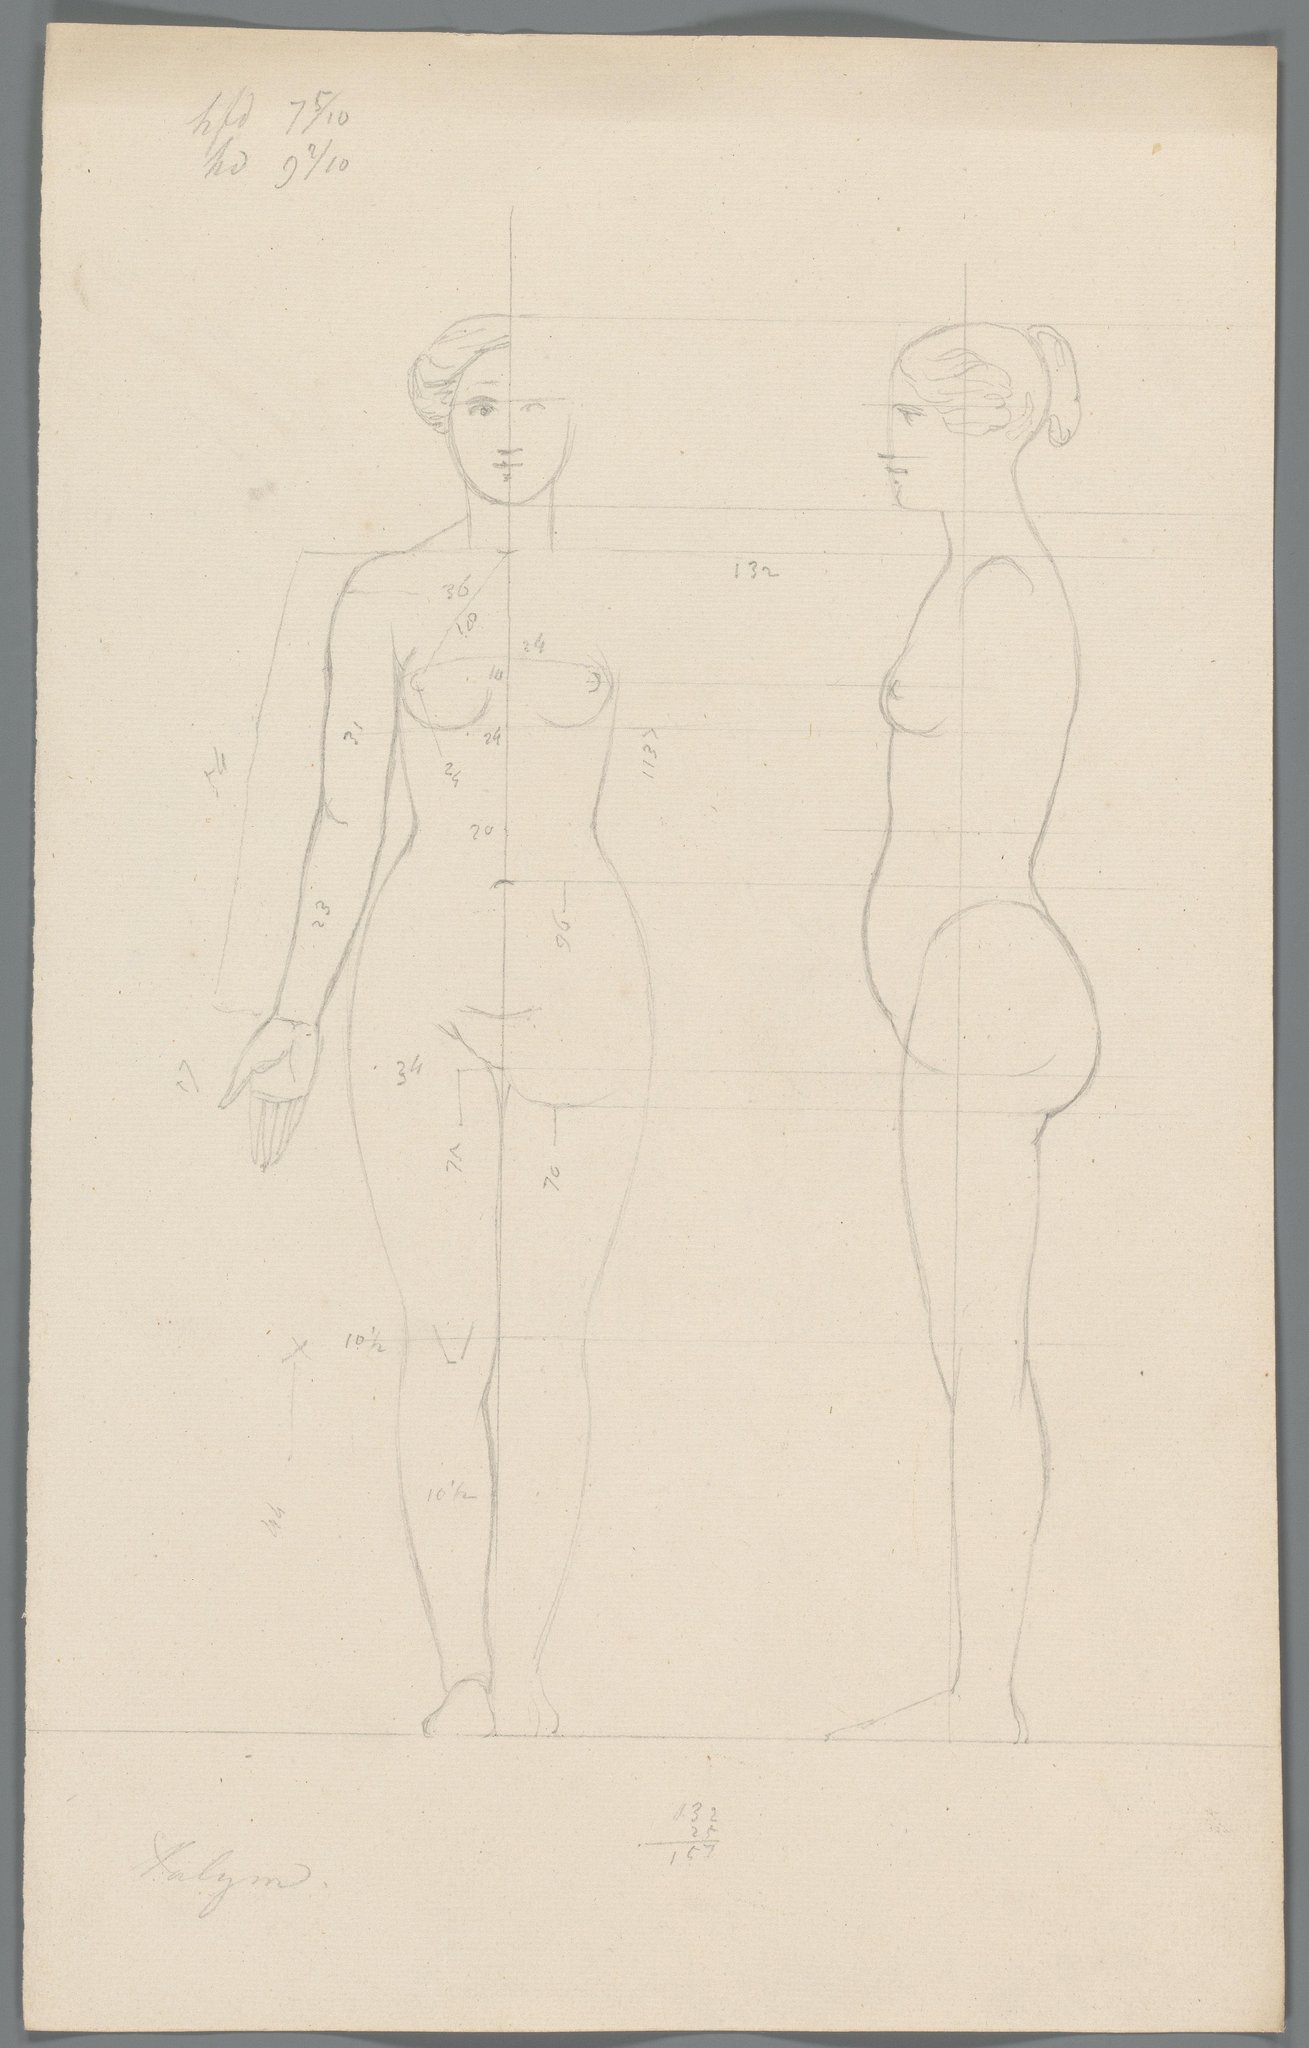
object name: drawing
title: Proportiestudie van een vrouw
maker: jacobus everhardus josephus van den berg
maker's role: draughtsman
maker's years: 1802-1861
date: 1812-1861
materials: paper, pencil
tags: standing figure (canon, proportions) - aa - female human figure, anatomy (non-medical) - aa - female human figure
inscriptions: inscription: ‘Xalym’